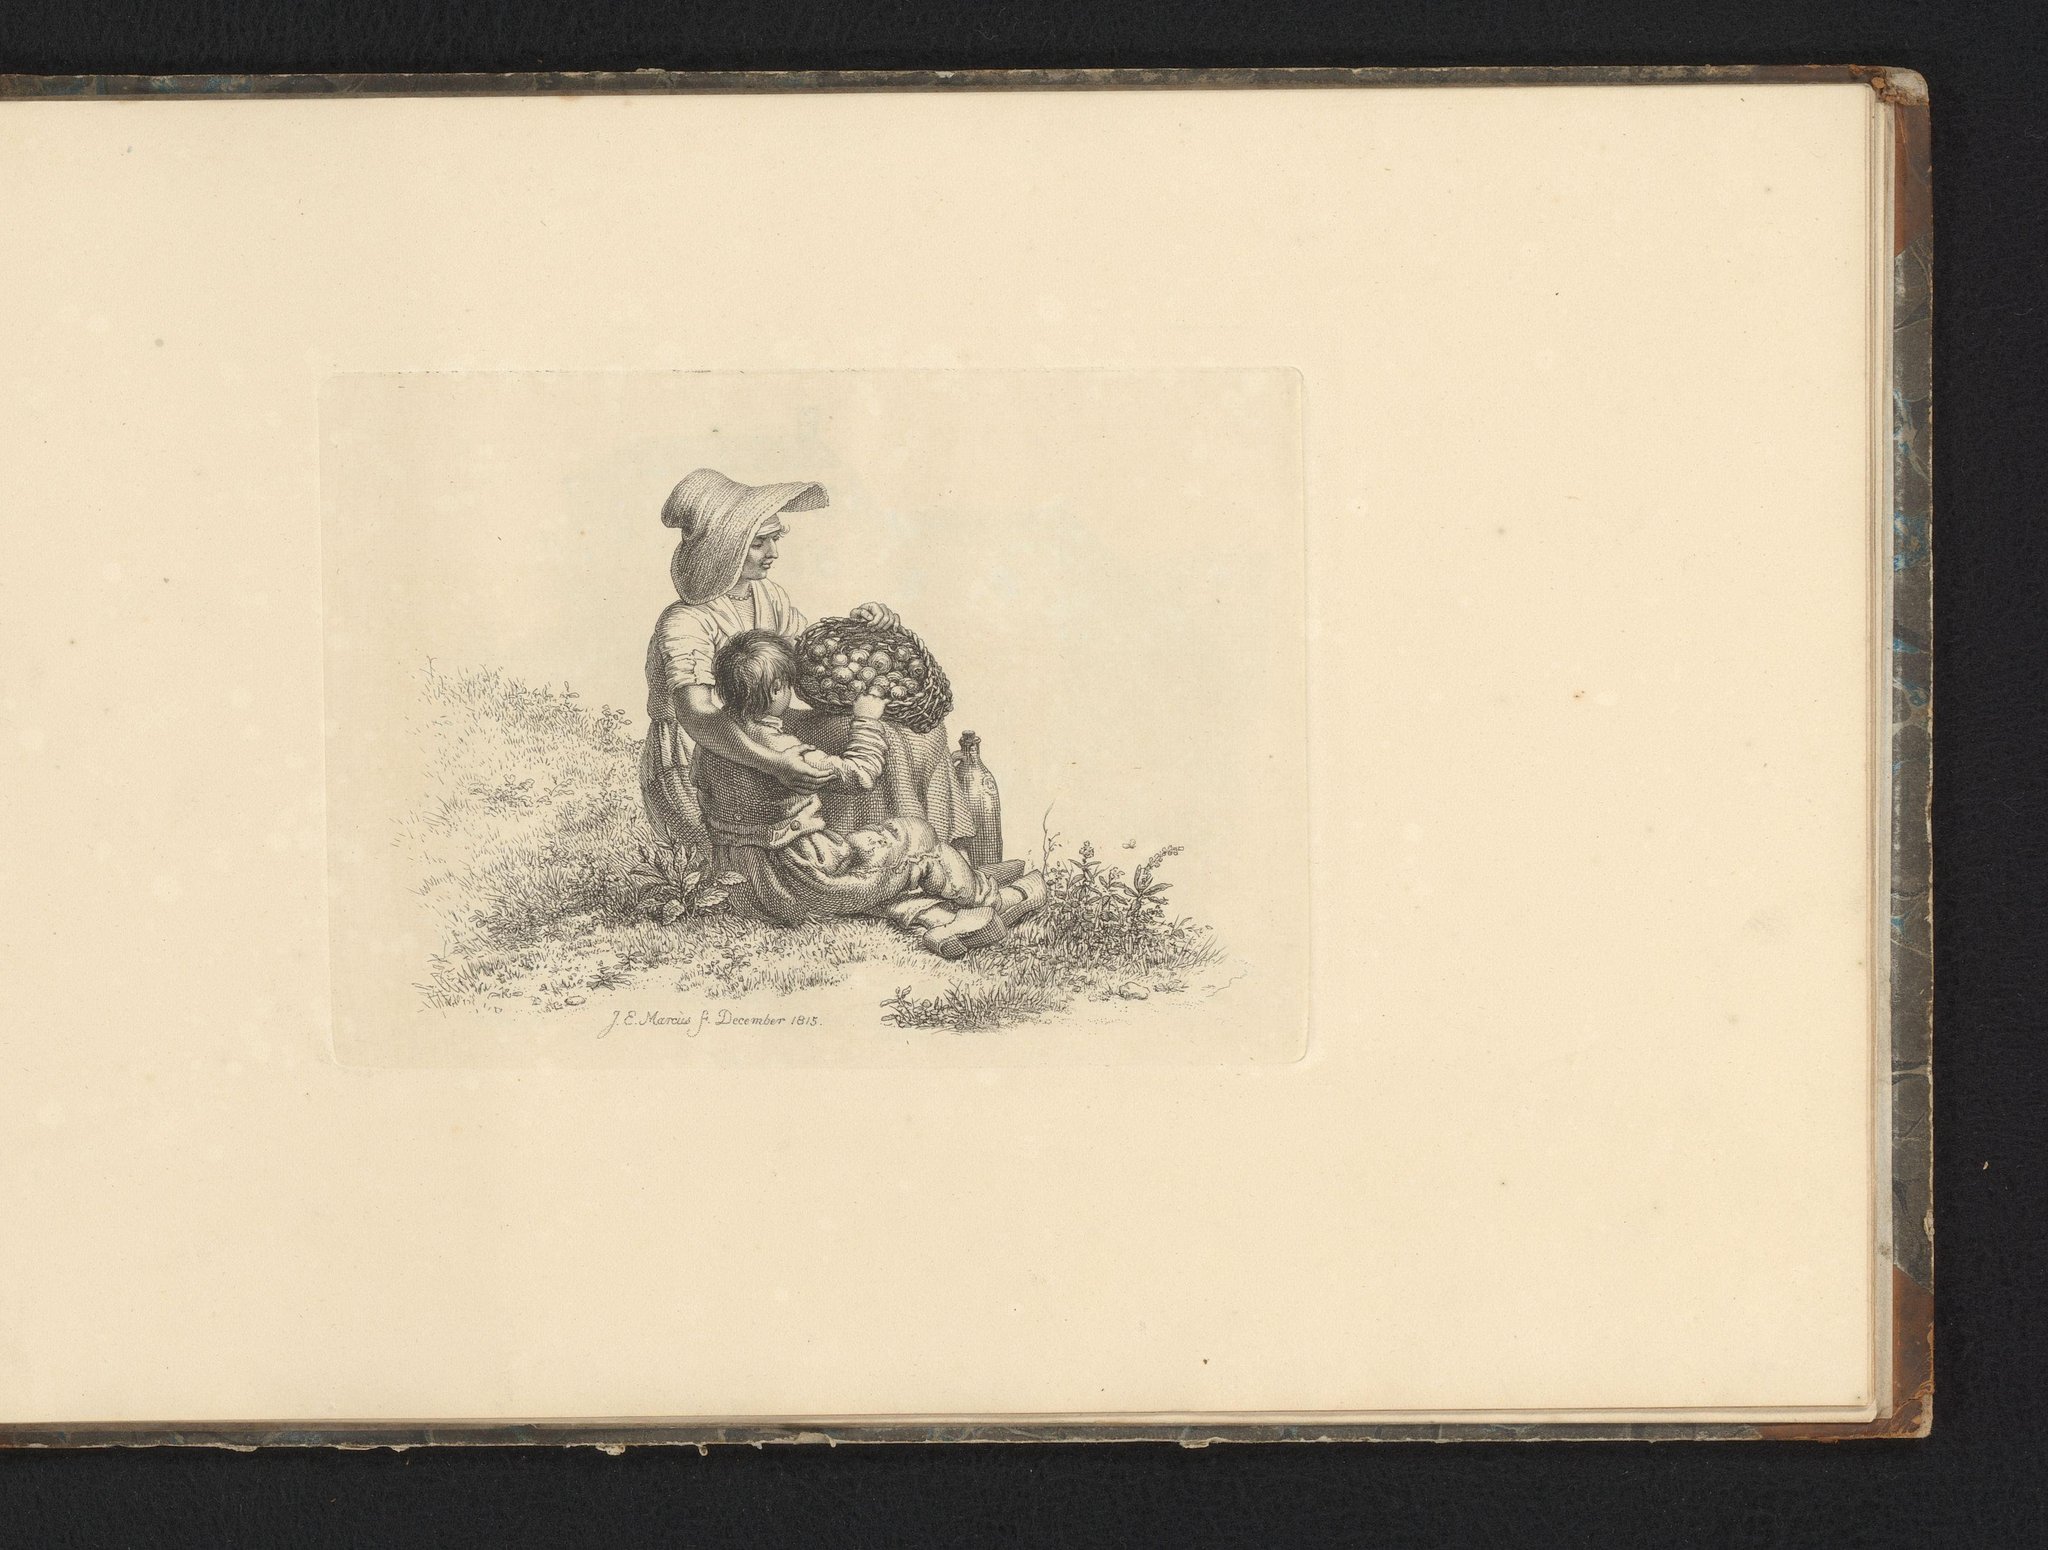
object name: album leaf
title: Moeder en zoon zittend met mand en fles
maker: jacob ernst marcus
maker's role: draughtsman, print maker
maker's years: 1774-1826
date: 1812-1815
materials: paper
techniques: etching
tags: mother and son(s) (family group), container made of plant material other than wood: basket, container of glass: bottle, jar, vase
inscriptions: date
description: Deze prent maakt deel uit van een album.